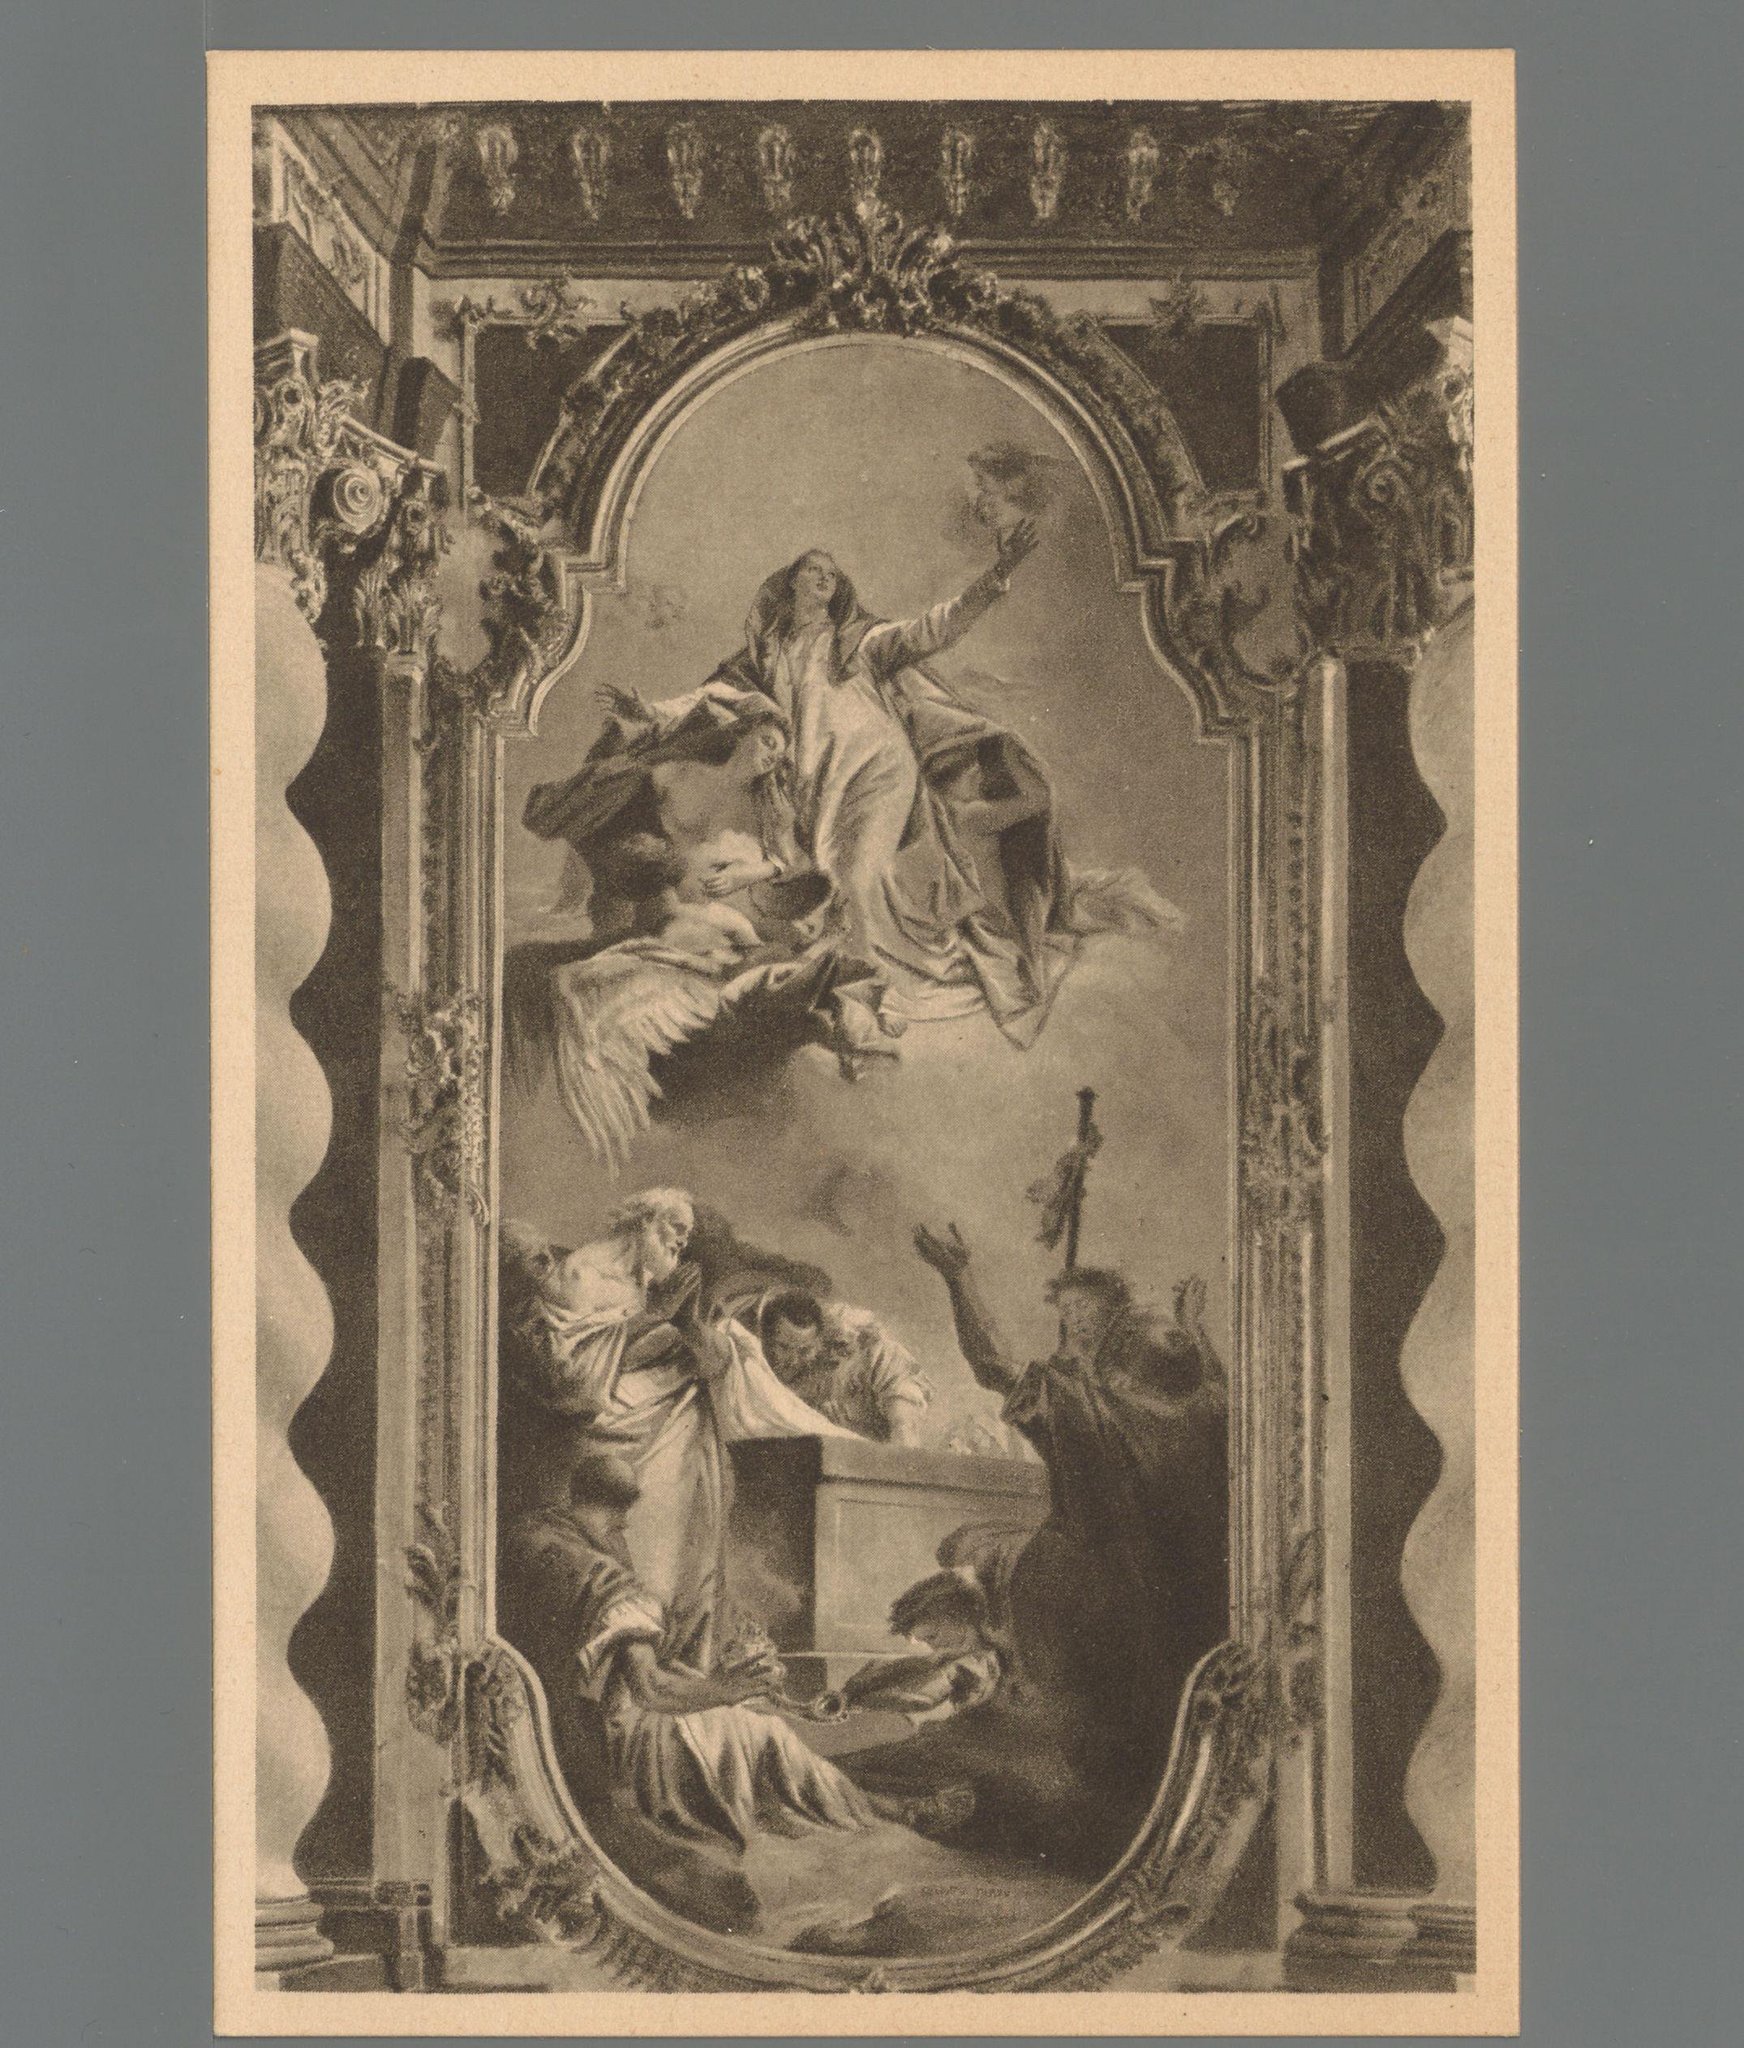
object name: photomechanical print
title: Würzburg, Residenz G.B. Tiepolo, Maria Himmelfahrt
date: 1905-1950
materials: cardboard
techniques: rotogravure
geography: würzburg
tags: palace, picture, painting